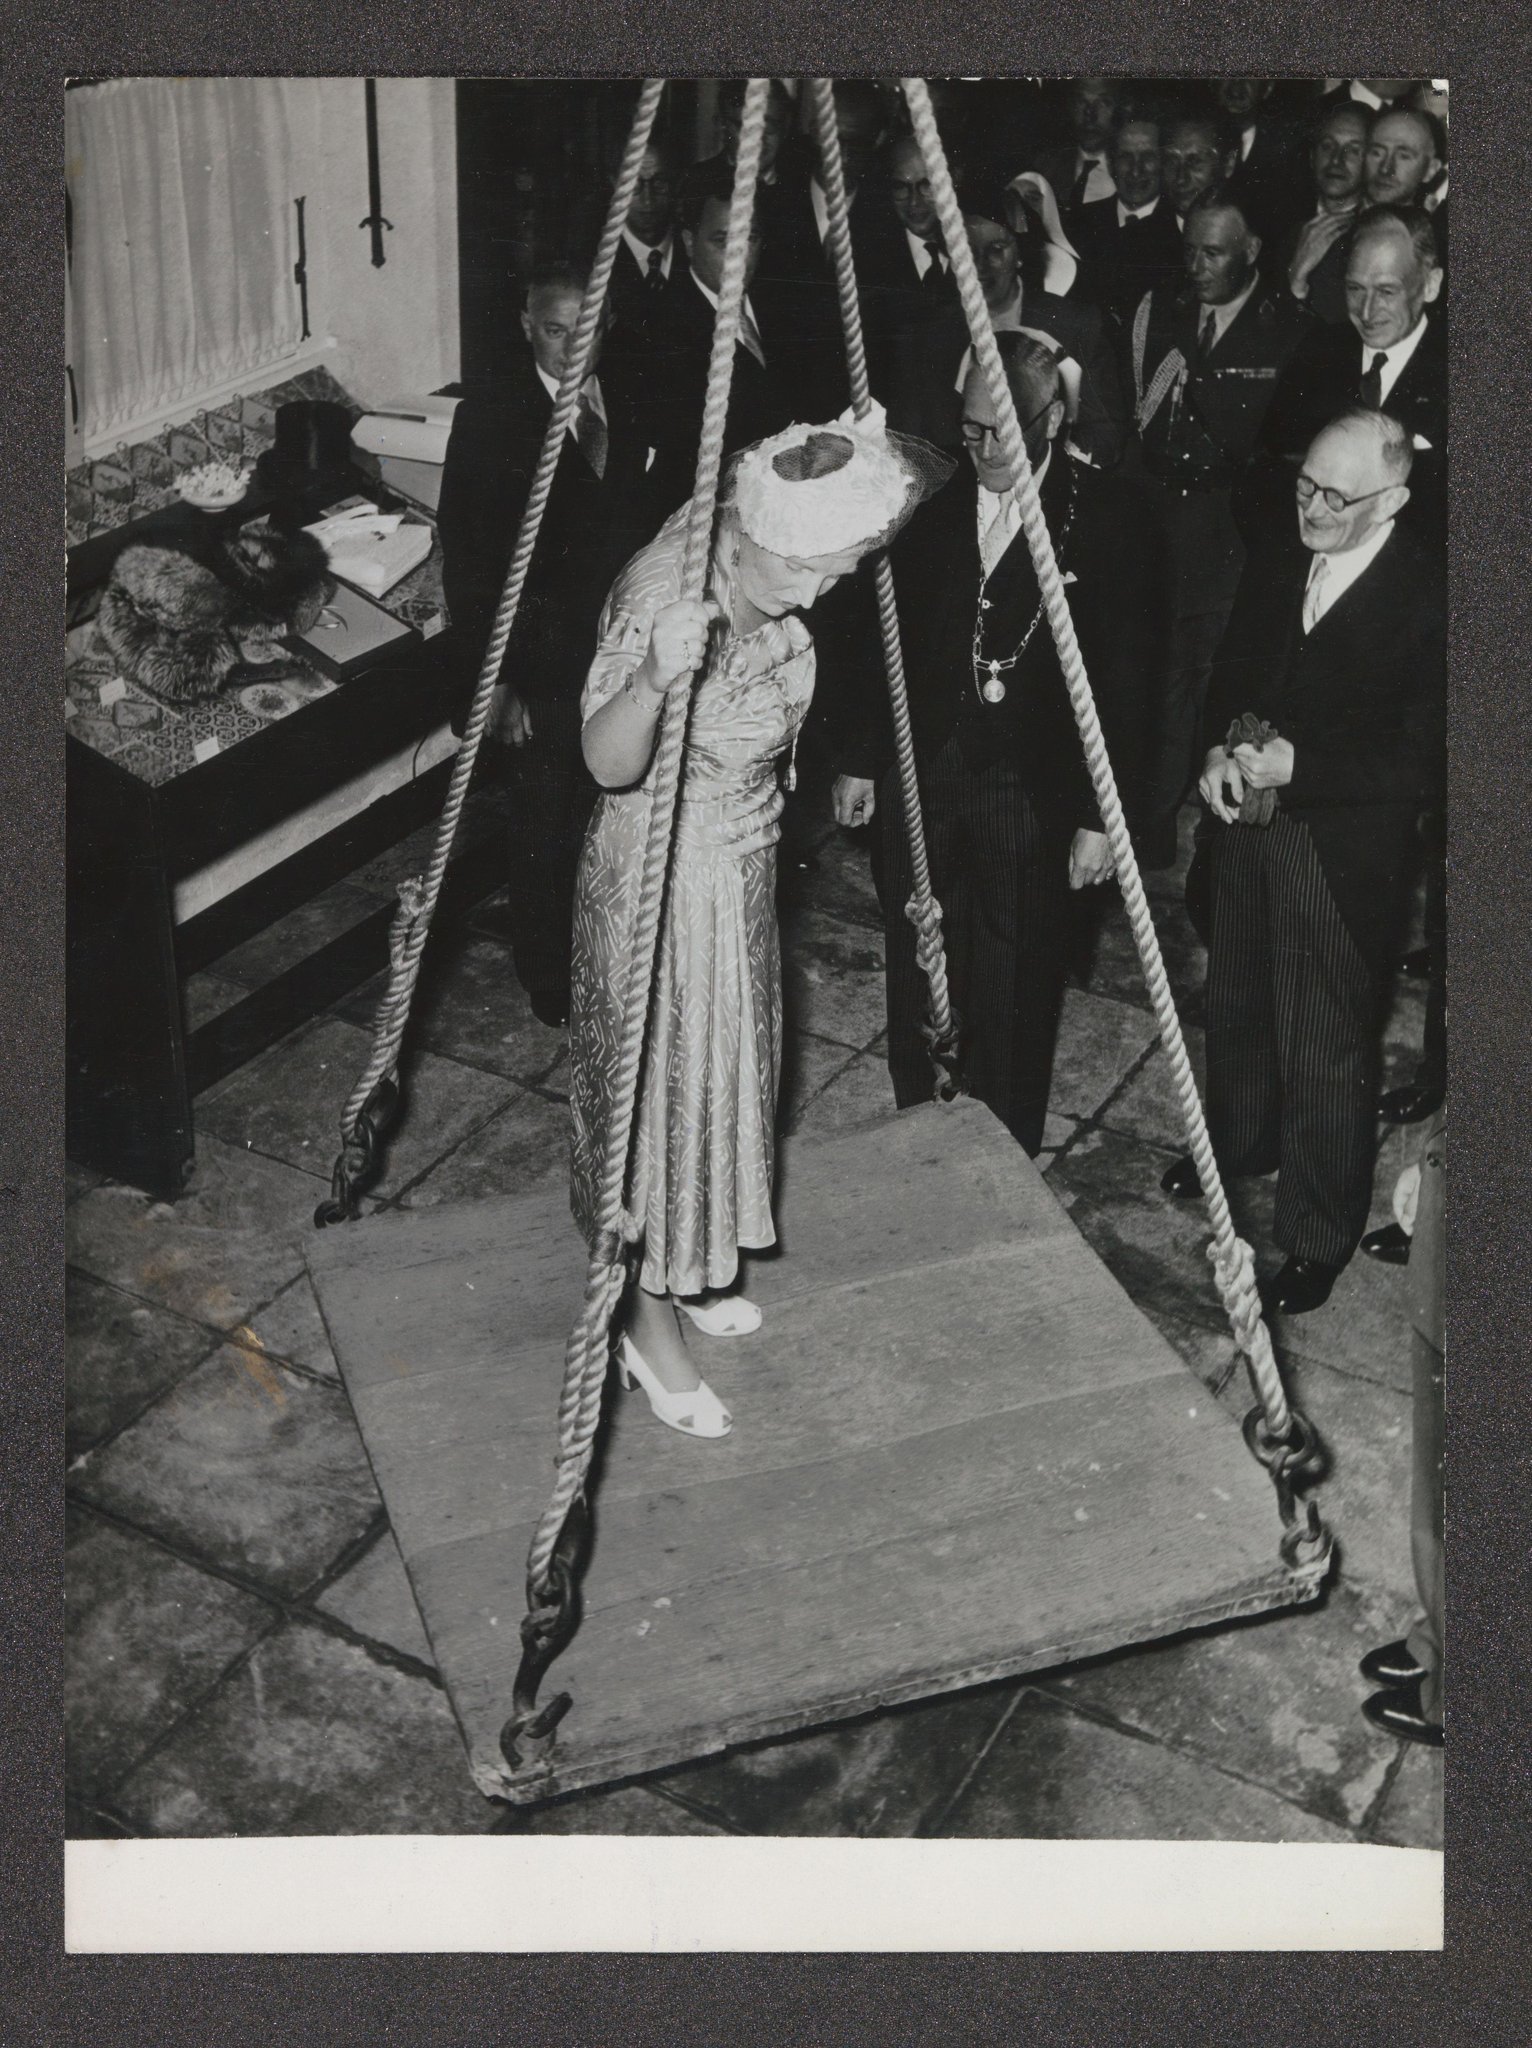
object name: photograph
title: H.M. Queen Juliana to-day visited Oudewater, north of Rotterdam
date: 1952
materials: cardboard, paper, photographic support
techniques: gelatin silver print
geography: netherlands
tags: juliana of the netherlands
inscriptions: annotation: ‘In the building Heksenwaag the weighing house of this little town the queen had been weighed als at the balance’